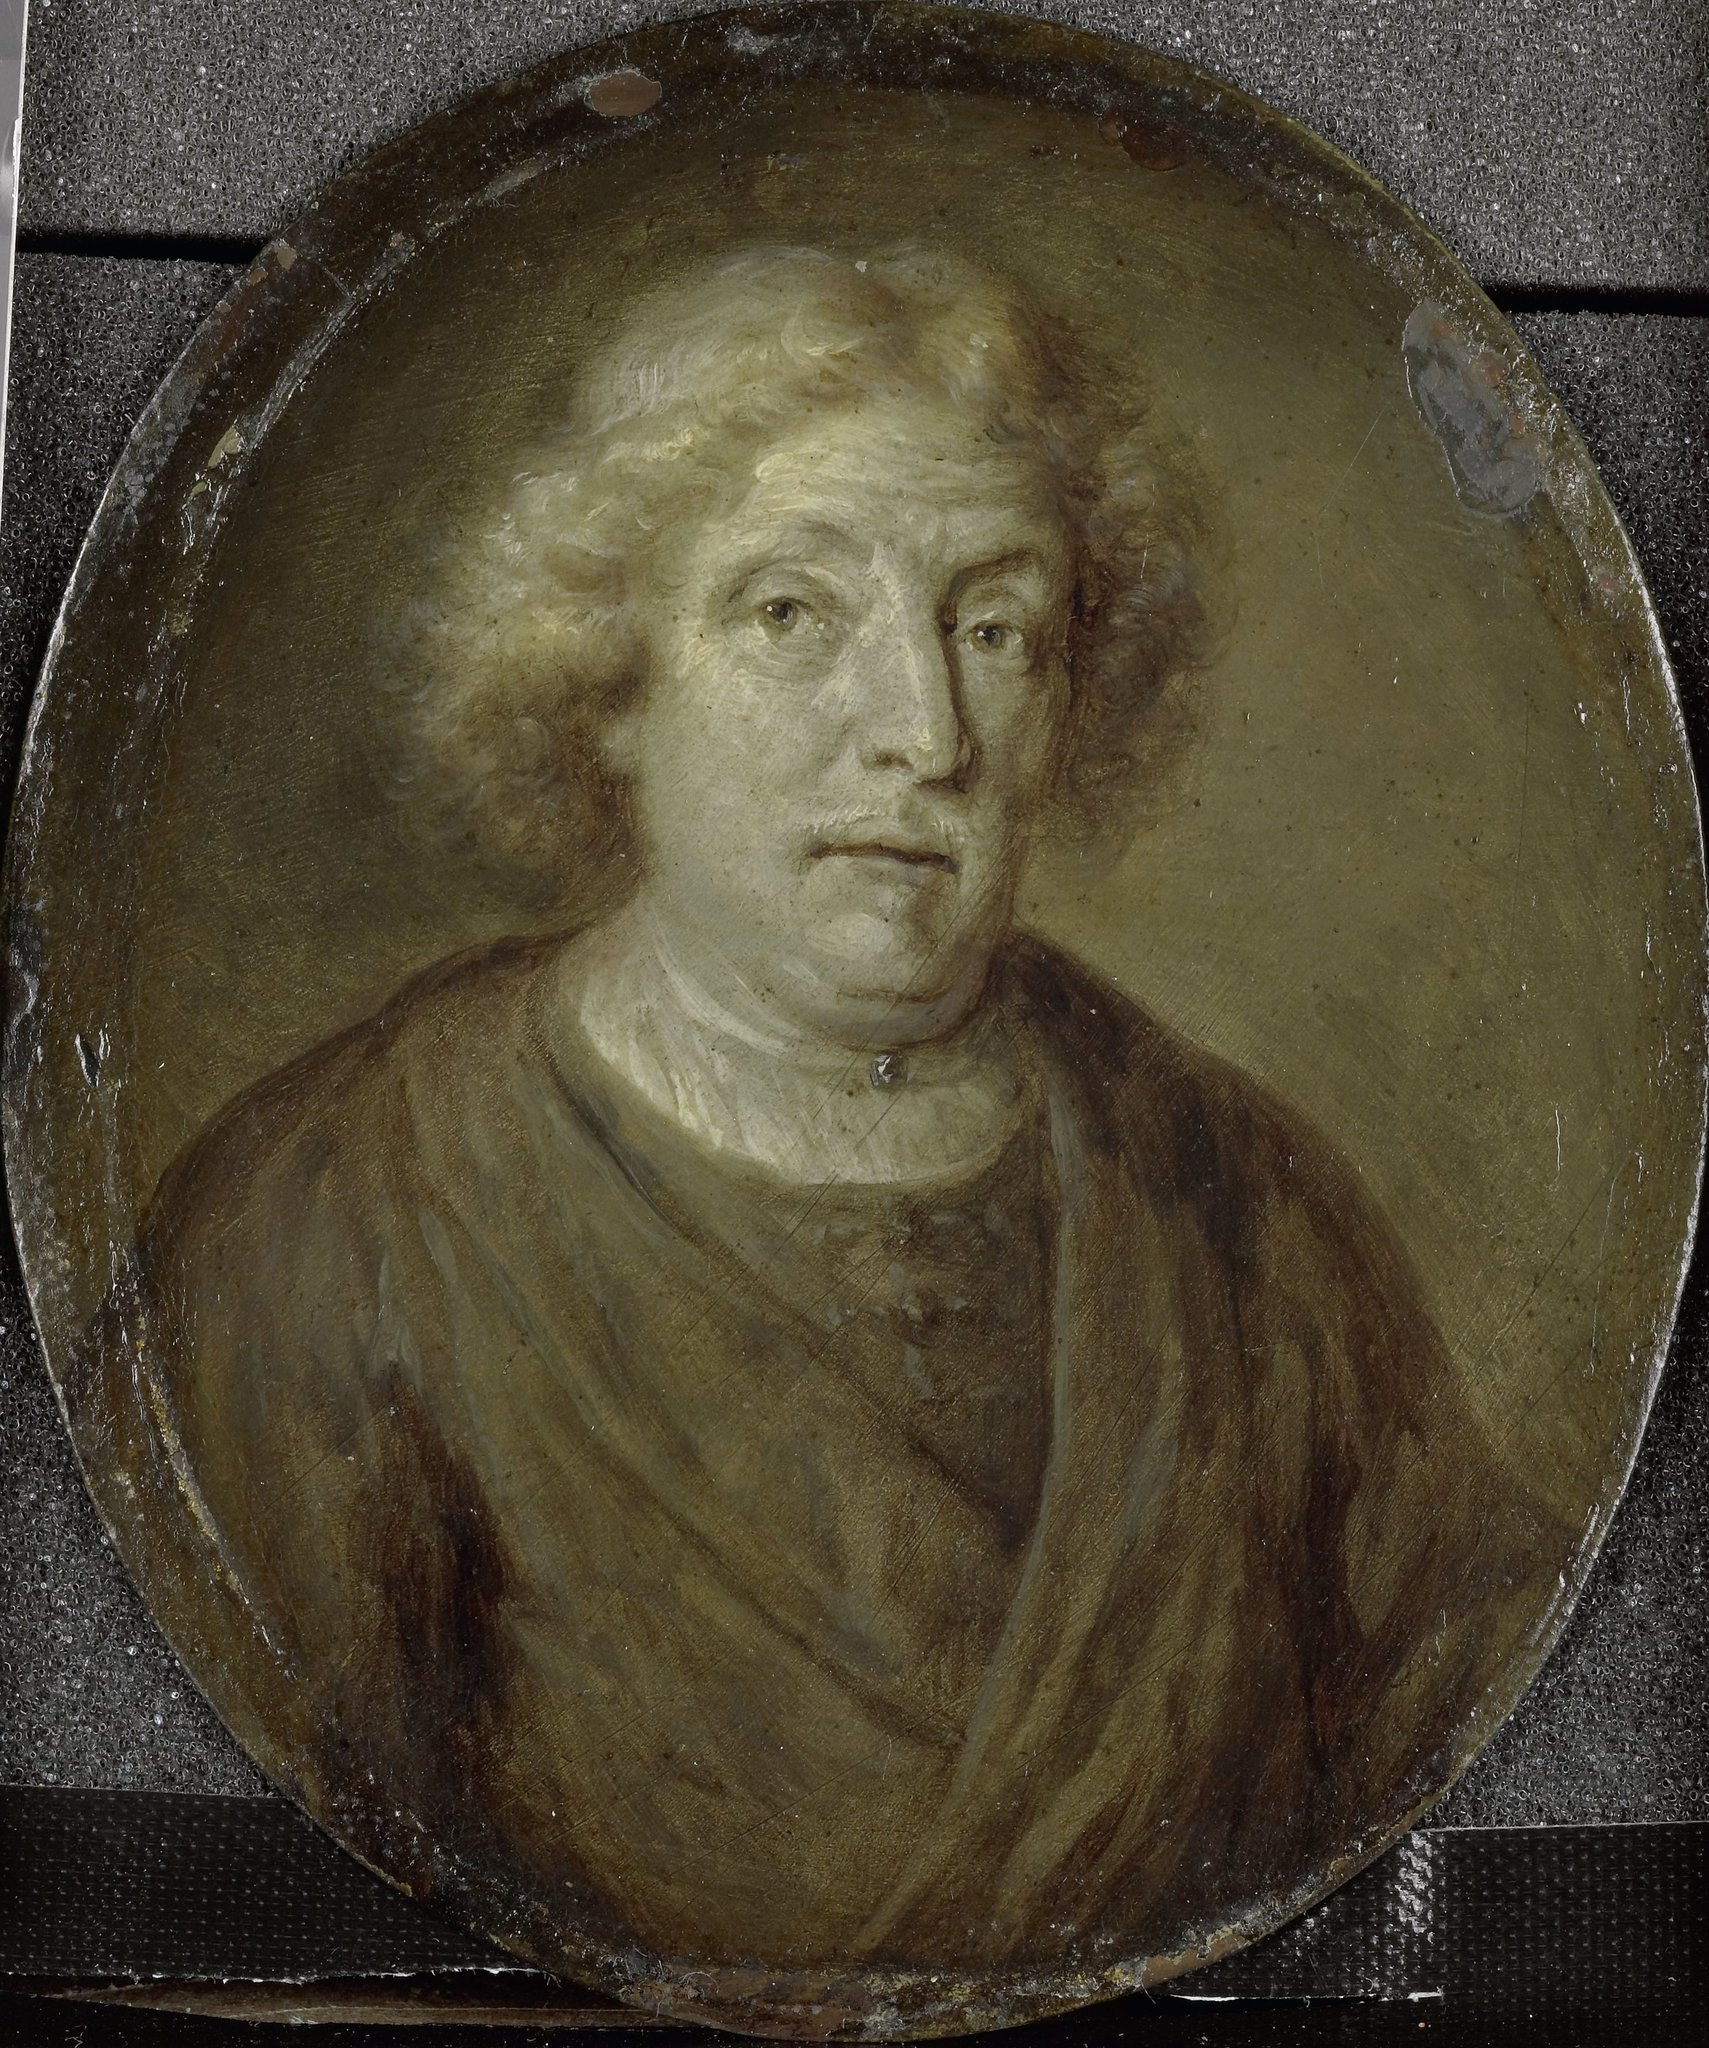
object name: painting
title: Portrait of Jacob Lescailje, Bookdealer and Poet in Amsterdam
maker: jan maurits quinkhard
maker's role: draughtsman, painter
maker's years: 1688-1772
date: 1732-1771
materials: copper, oil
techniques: grisaille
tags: jacob lescaille, portrait of a writer, publishing, publisher, writer, poet, author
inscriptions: inscription: ‘Jb Lescailje. 1611’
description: Portret van Jacob Lescaille (1611-79). Boekhandelaar en dichter te Amsterdam. Buste in ovaal, naar rechts. Vervaardigd naar een onbekend voorbeeld. Onderdeel van een verzameling portretten van Nederlandse dichters.